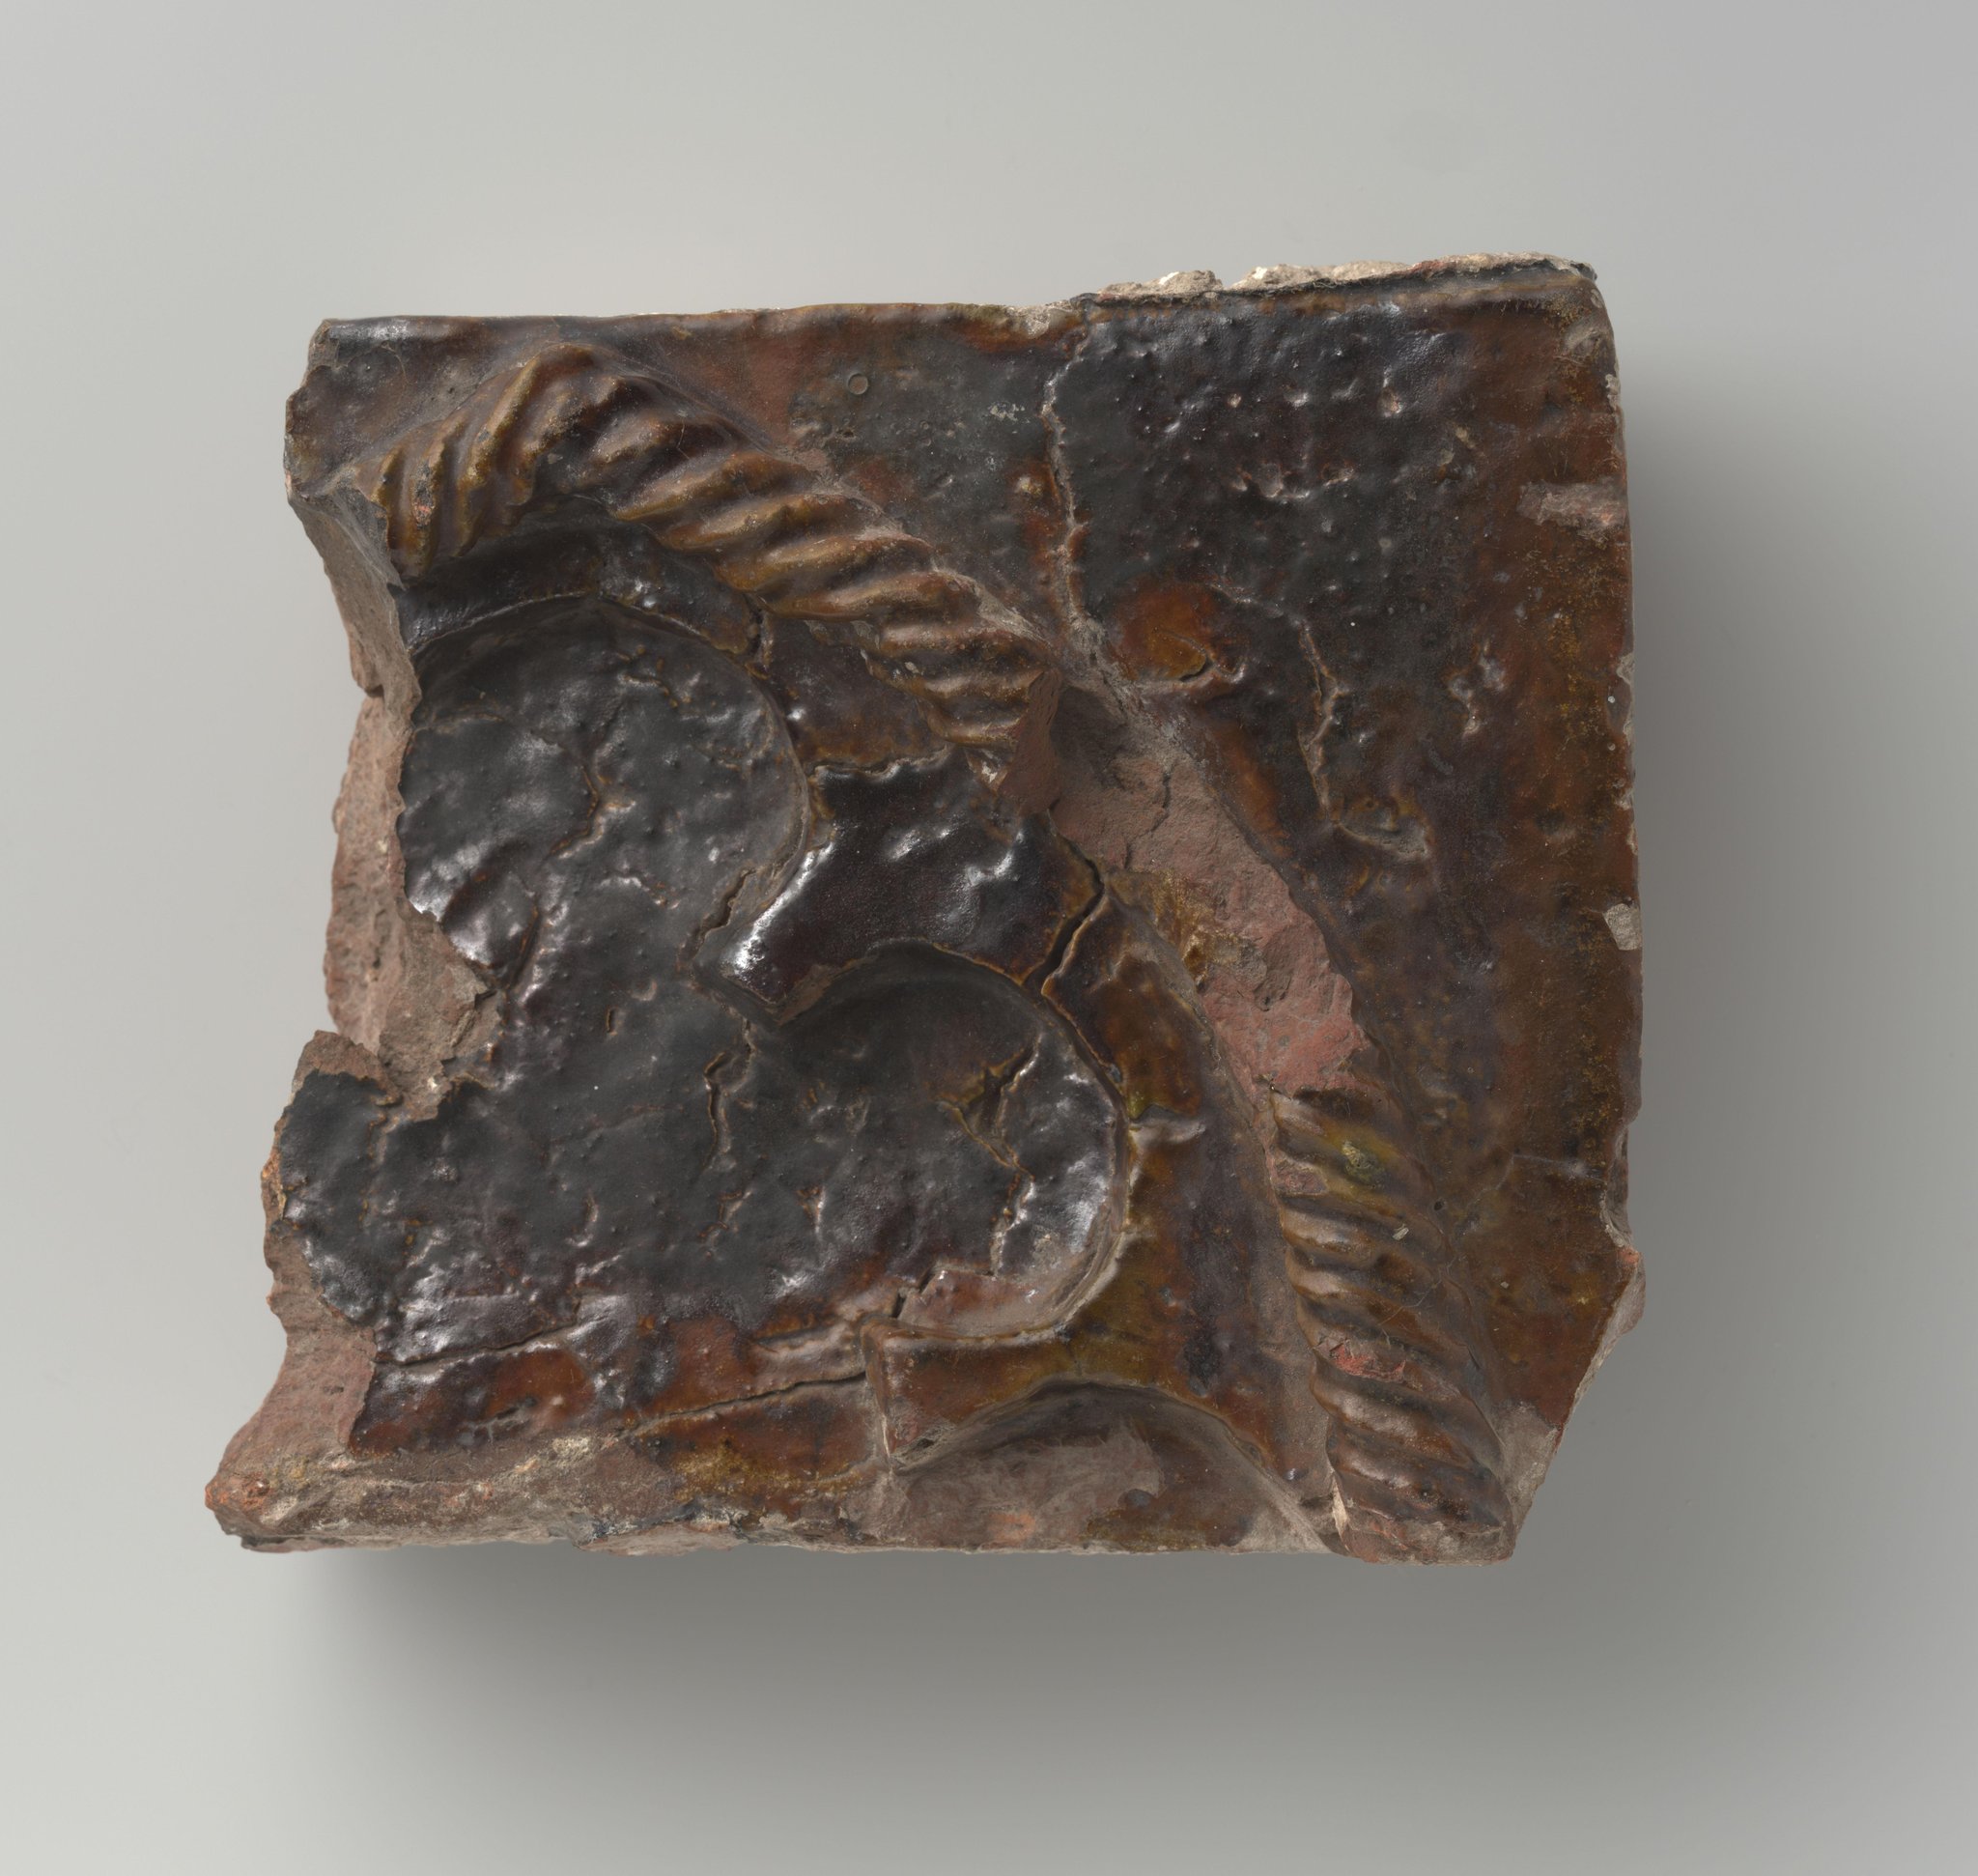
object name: brick clay product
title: Baksteen, afkomstig van de abdij te Aduard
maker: Anonymous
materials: brick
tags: aduard abbey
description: Een fragment van een baksteen, vrijwel vierkant van vorm. Versierd met een verdiept aangebrachte, schuingeplaatste bogenrij, welke parallel loopt met een kraal met touwmotief, die evenwel van onderen plotseling met scherpe hoek ombuigt. Bovenkant geheel bedekt met loodglazuur, waarin sporen van groen en goudbruin. Afkomstig van de Abdij te Aduard.